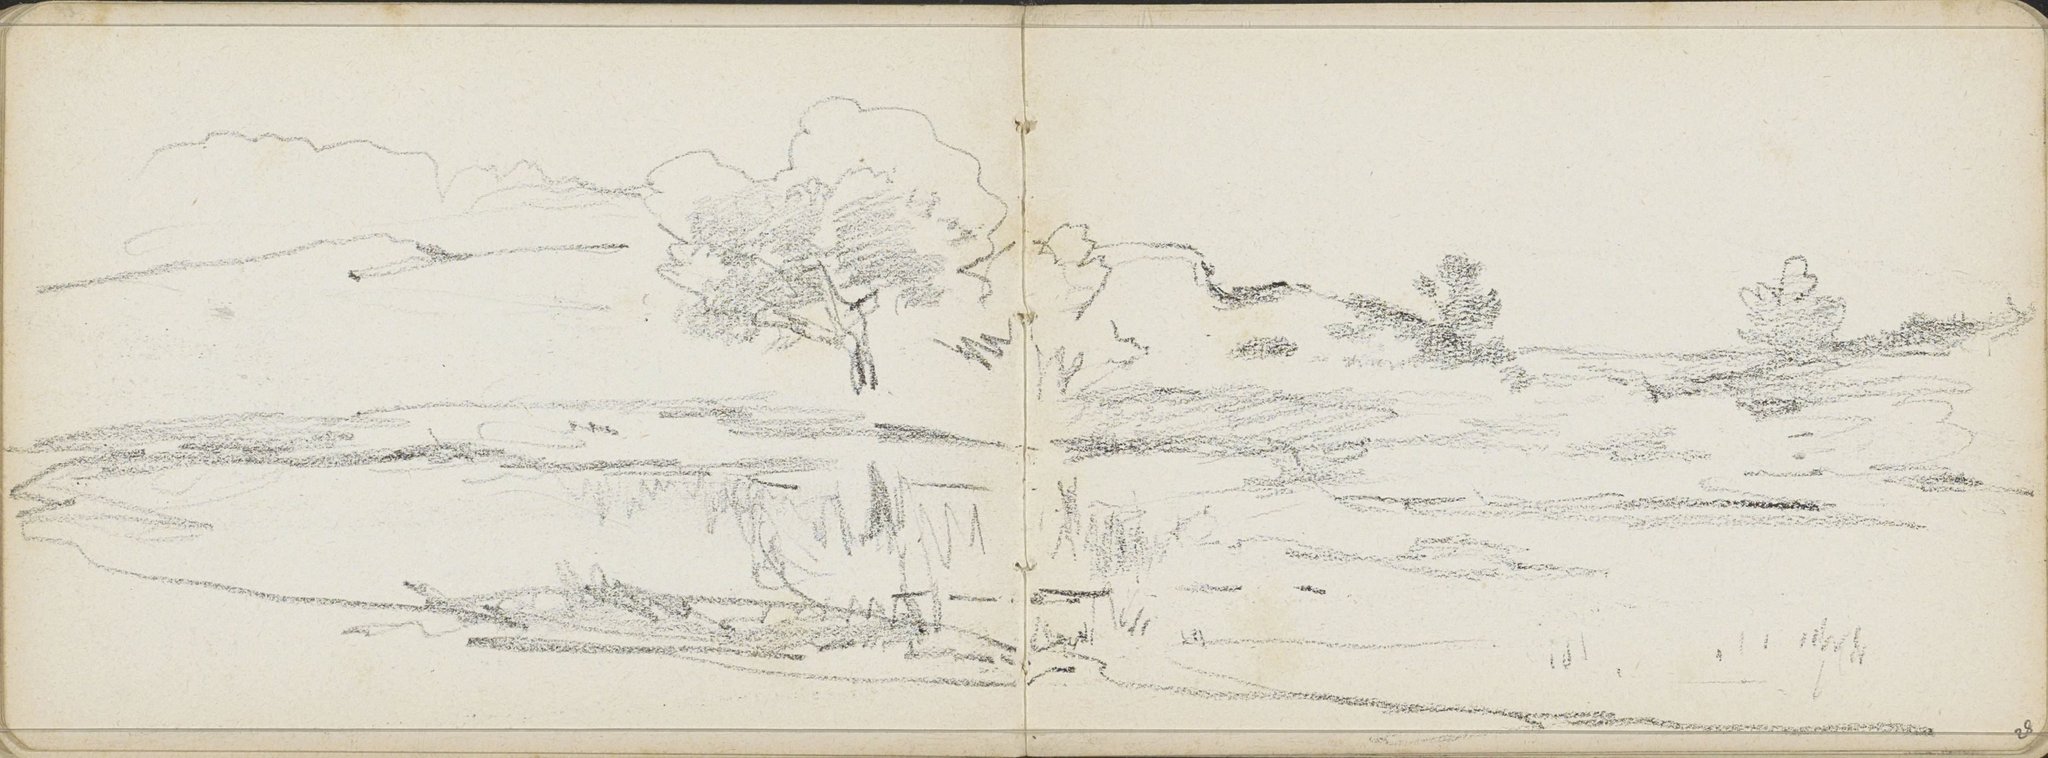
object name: sketchbook leaf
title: Landschap met bomen en water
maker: willem cornelis rip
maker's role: draughtsman, painter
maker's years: 1856-1922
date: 1866-1922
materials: chalk, paper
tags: trees, landscapes with waters, waterscapes, seascapes (in the temperate zone)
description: Blad 27 verso en 28 recto uit een schetsboek met 42 bladen.